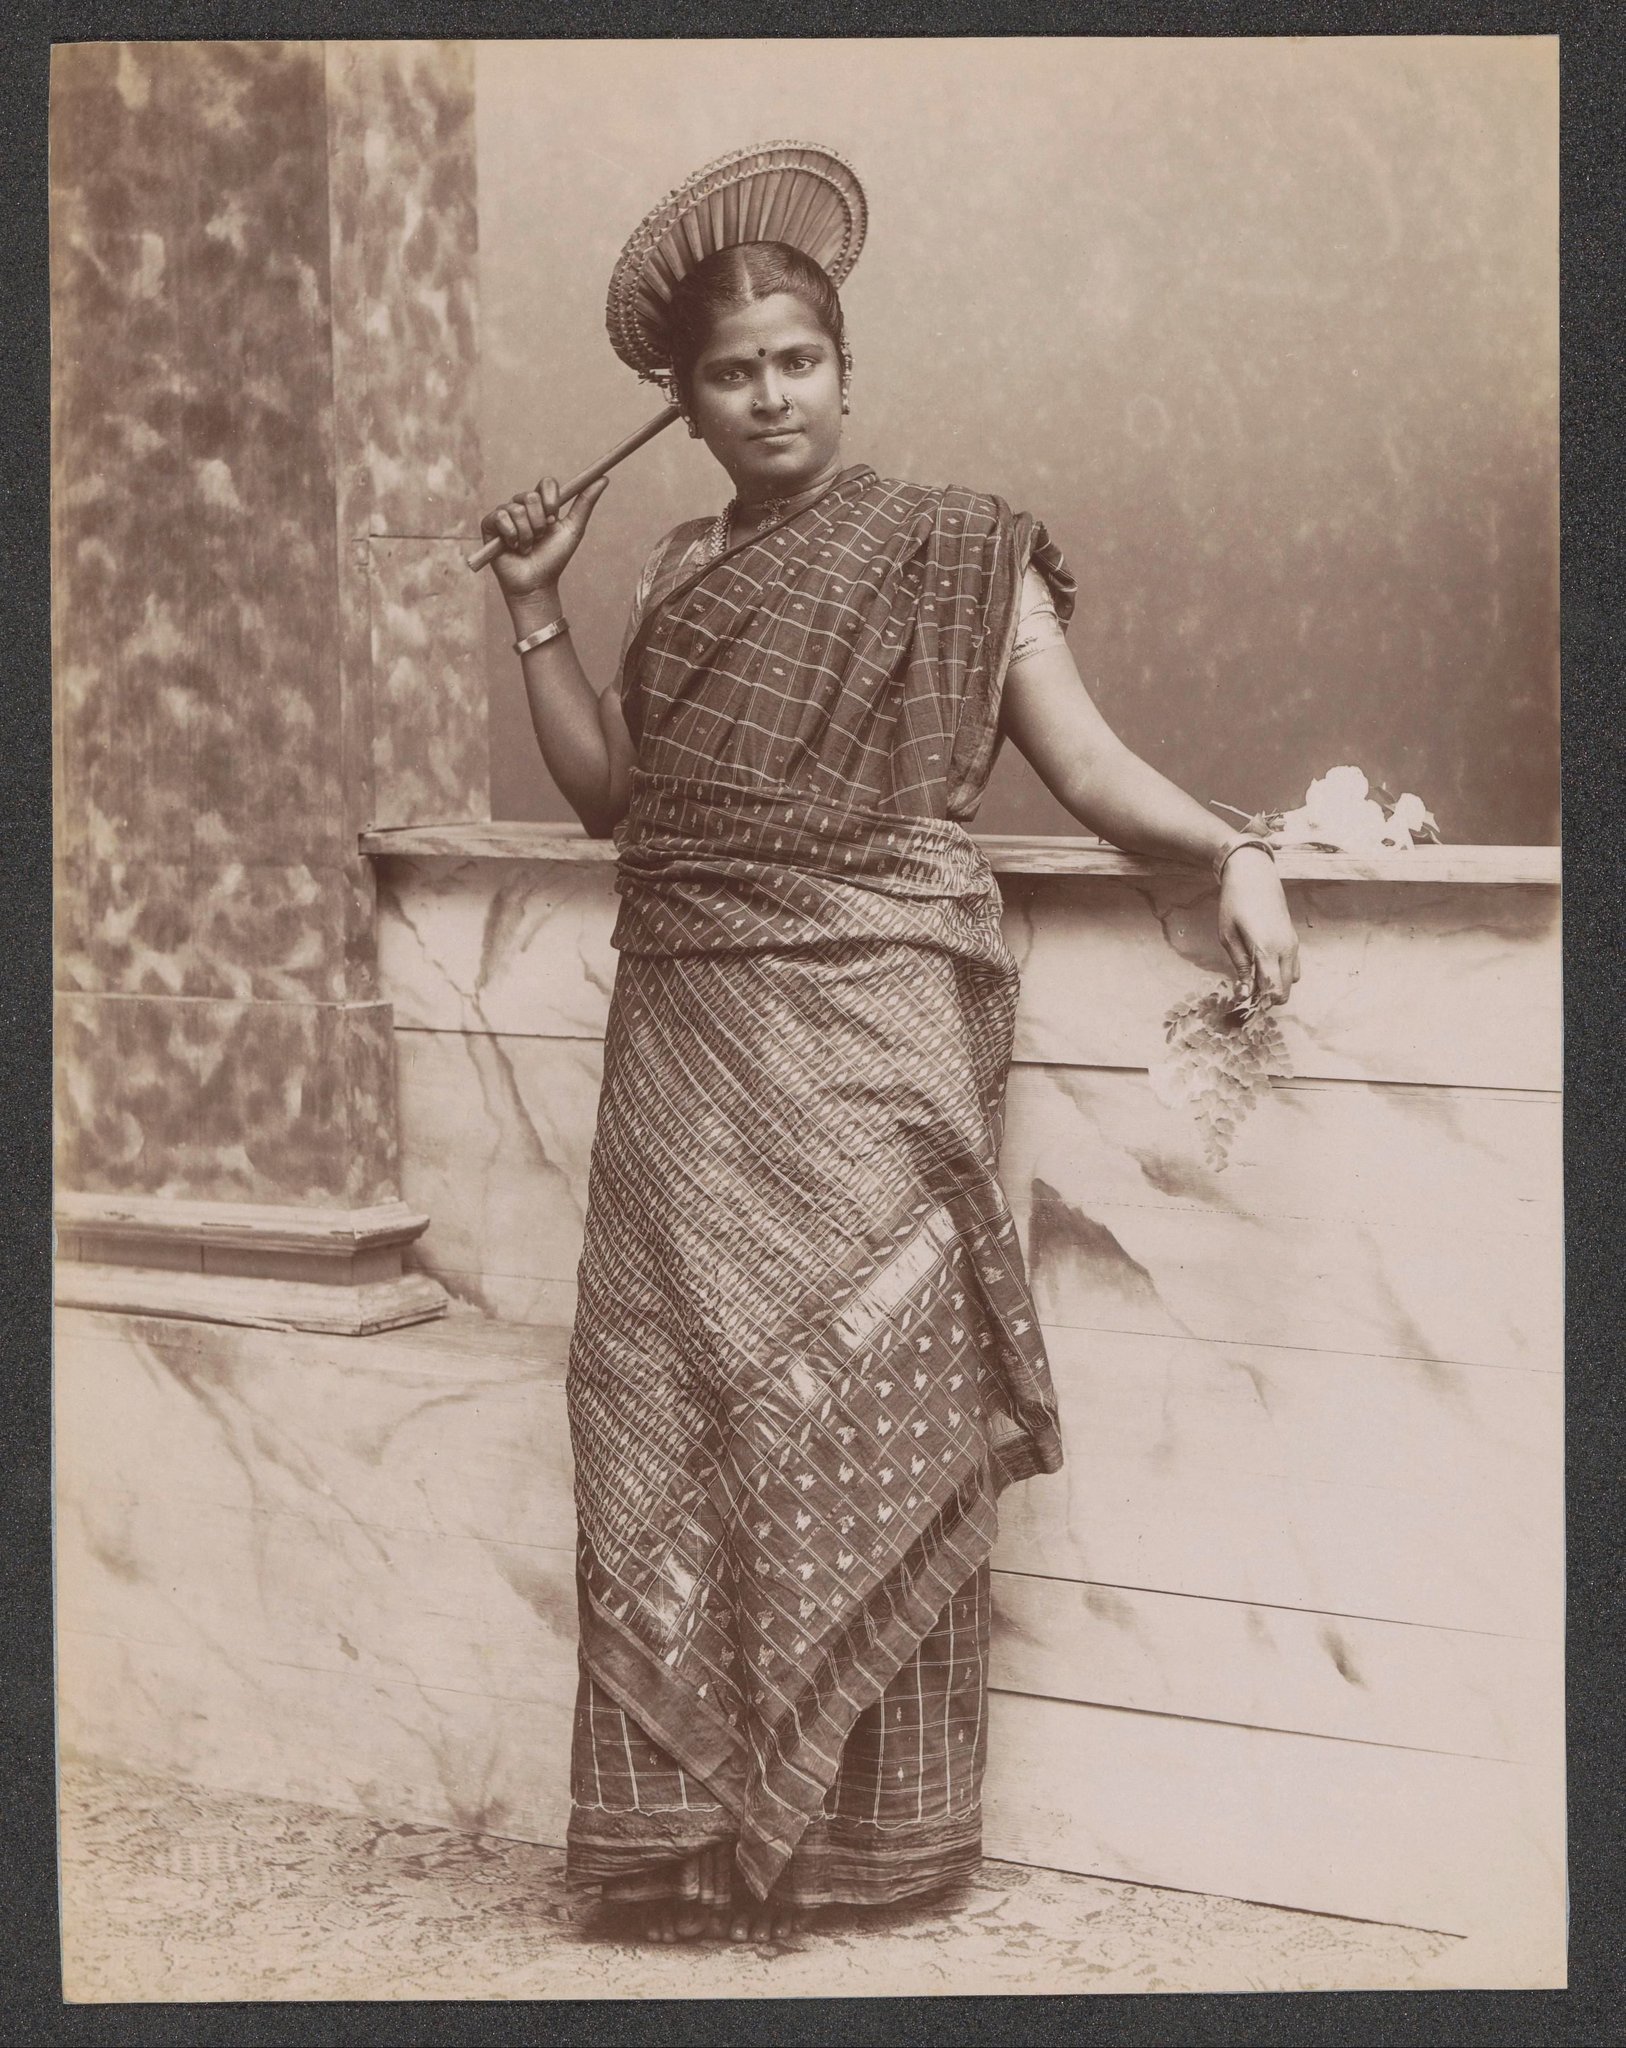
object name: photograph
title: Studio portrait of an unknown woman, Sri Lanka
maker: Anonymous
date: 1870-1900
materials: paper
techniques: albumen print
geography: sri lanka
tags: adolescent, young woman, maiden, historical persons not known by name - bb - woman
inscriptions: inscription: ‘Meisje/ van/ Ceylon’